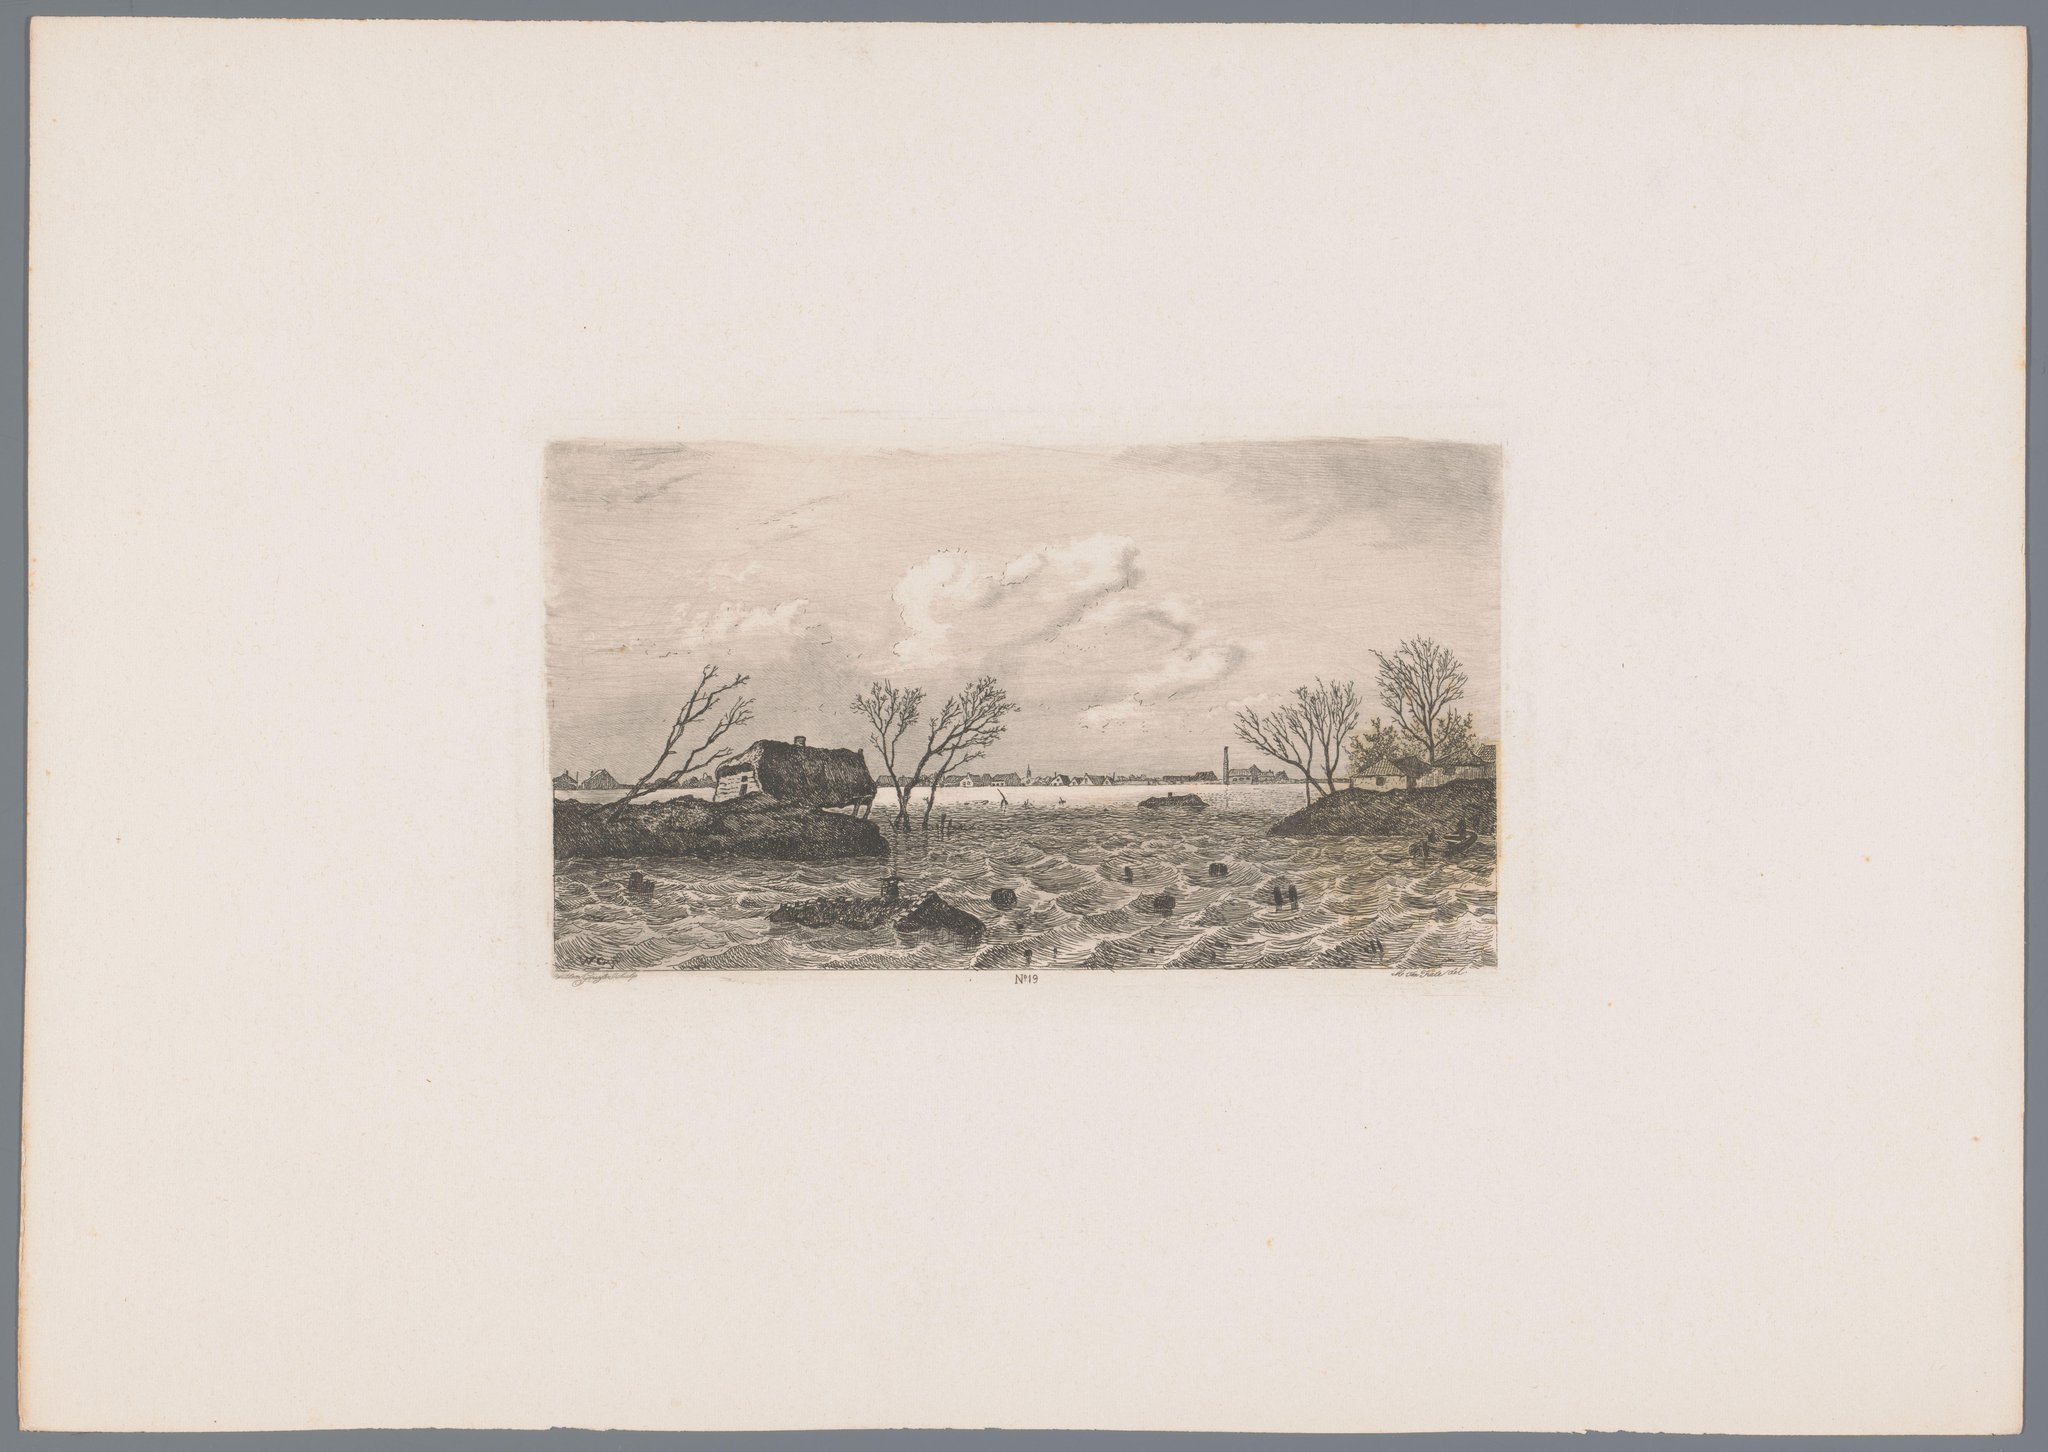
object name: print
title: Dijkdoorbraak bij Dreumel, 1855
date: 1855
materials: paper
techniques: etching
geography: netherlands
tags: dike-break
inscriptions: collector's mark: Lugt 2228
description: De doorgebroken dijk bij Dreumel, 9 maart 1855. Onderdeel van de reeks van 24 prenten over de watersnood van maart 1855, door leden van het genootschap Arti et Amicitiae. Uitgave ten behoeve van de slachtoffers van de watersnood.